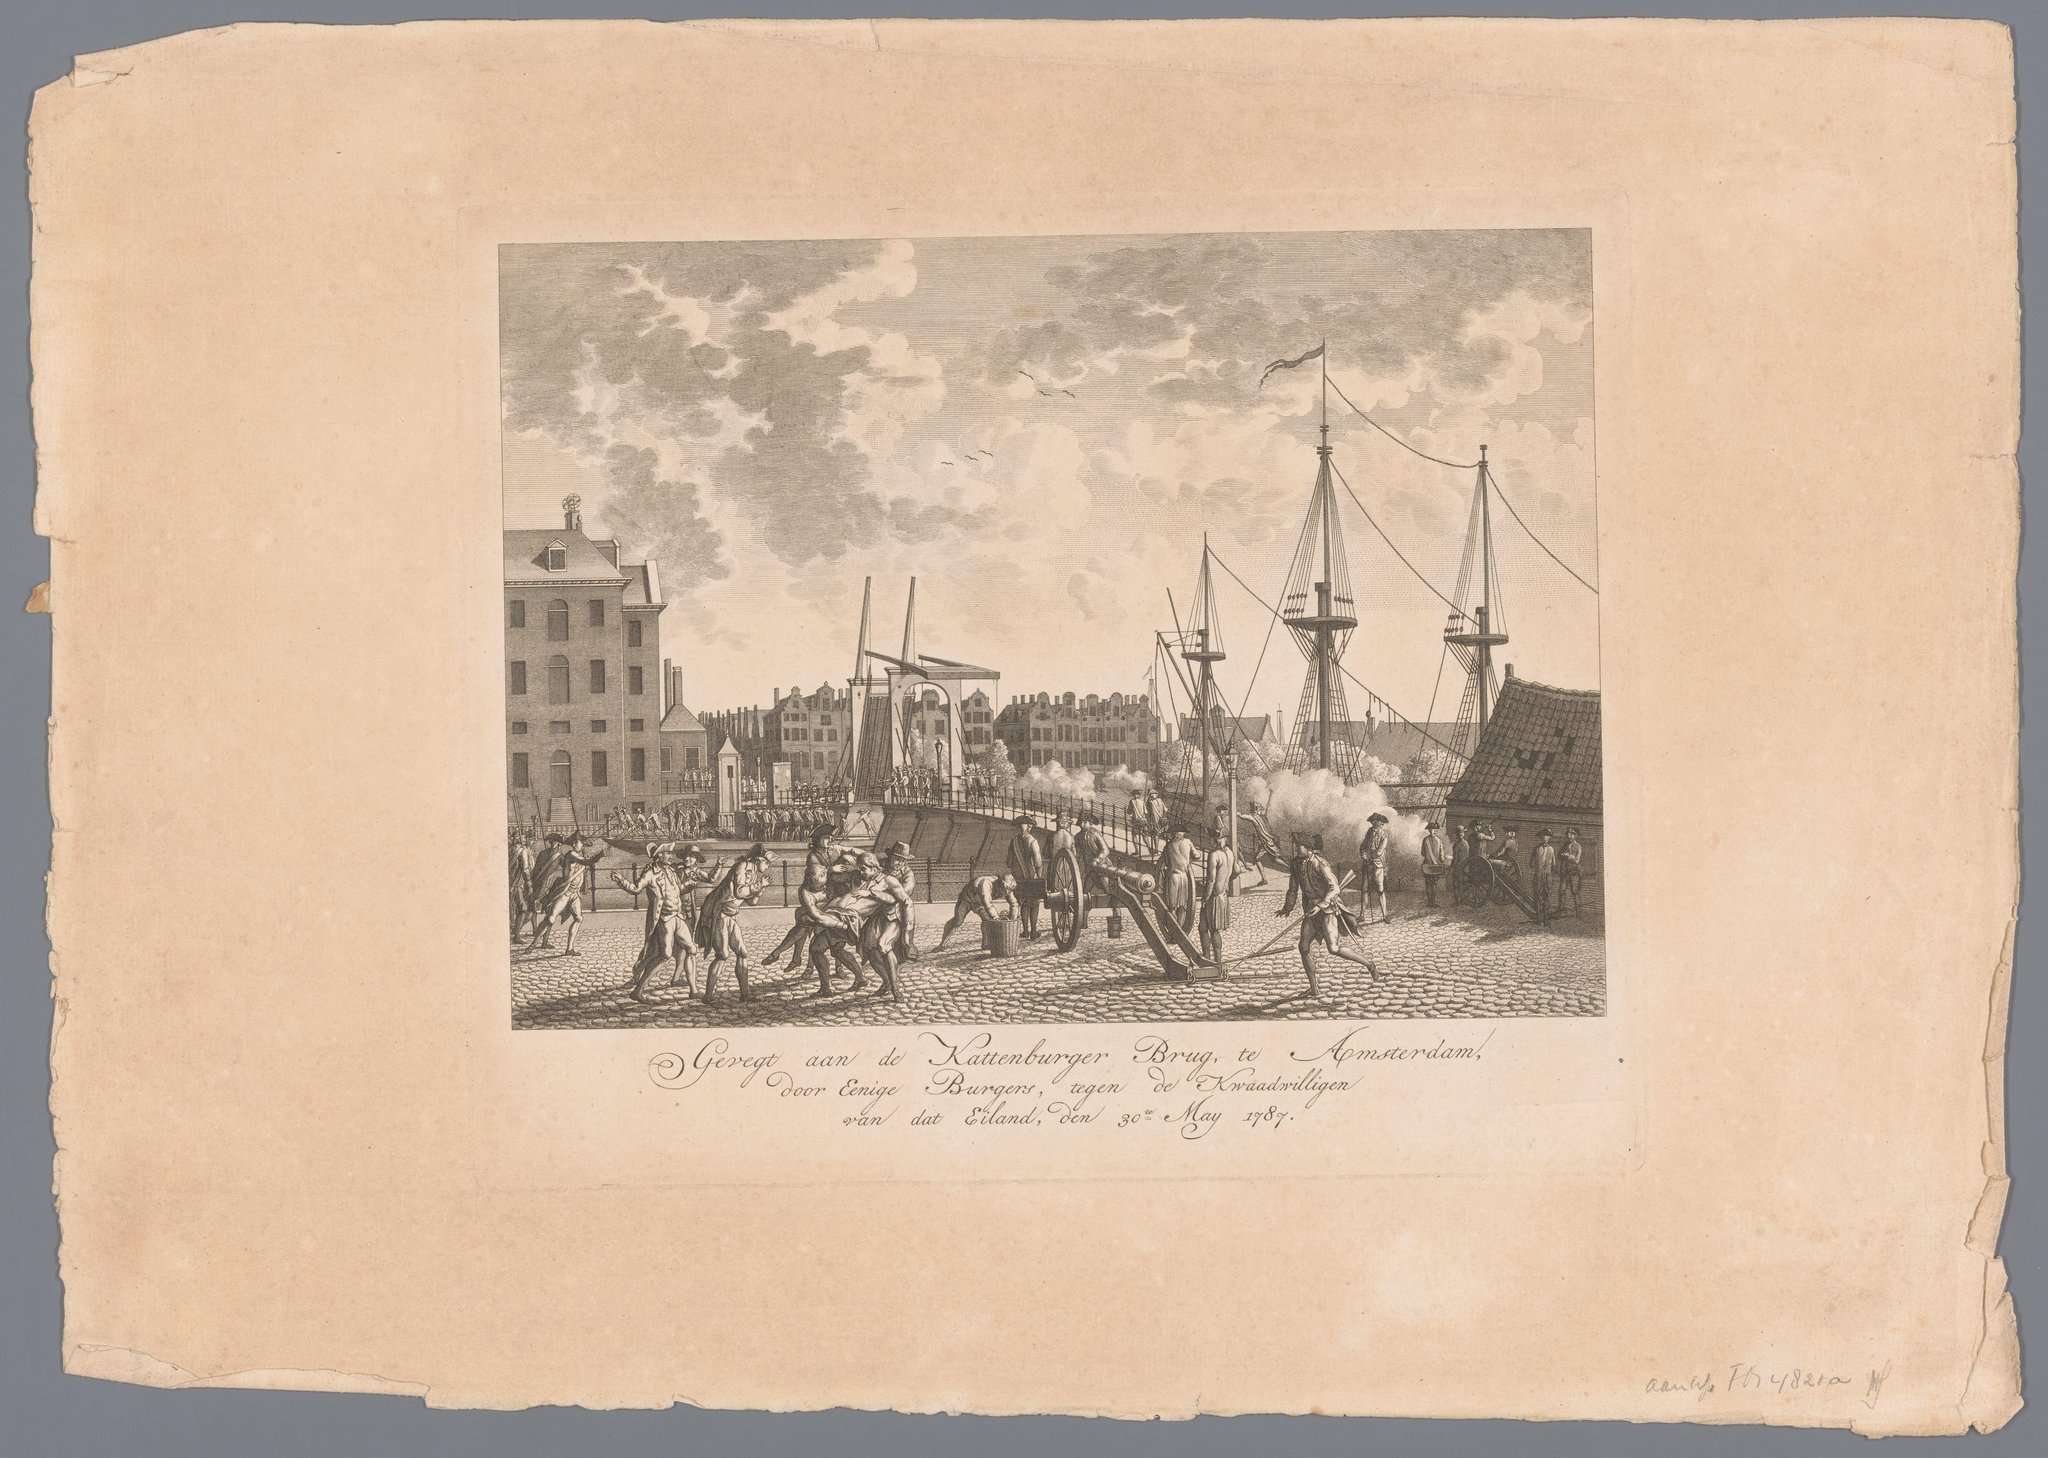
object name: print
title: Verovering van de Kattenburgerbrug, 1787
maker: Anonymous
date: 1787-1789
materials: paper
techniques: etching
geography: northern netherlands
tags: bridge in city across river, canal, etc. (+ city(-scape) with figures, staffage), battle (+ citizen soldiery, civil guard, citizen militia)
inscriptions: collector's mark: Lugt 2233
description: De verovering van de Kattenburgerbrug naar het eiland Kattenburg op de opstandige Oranjegezinden door de gewapende Amsterdamse burgers, 30 mei 1787. Links een deel van 's Lands Zeemagazijn.